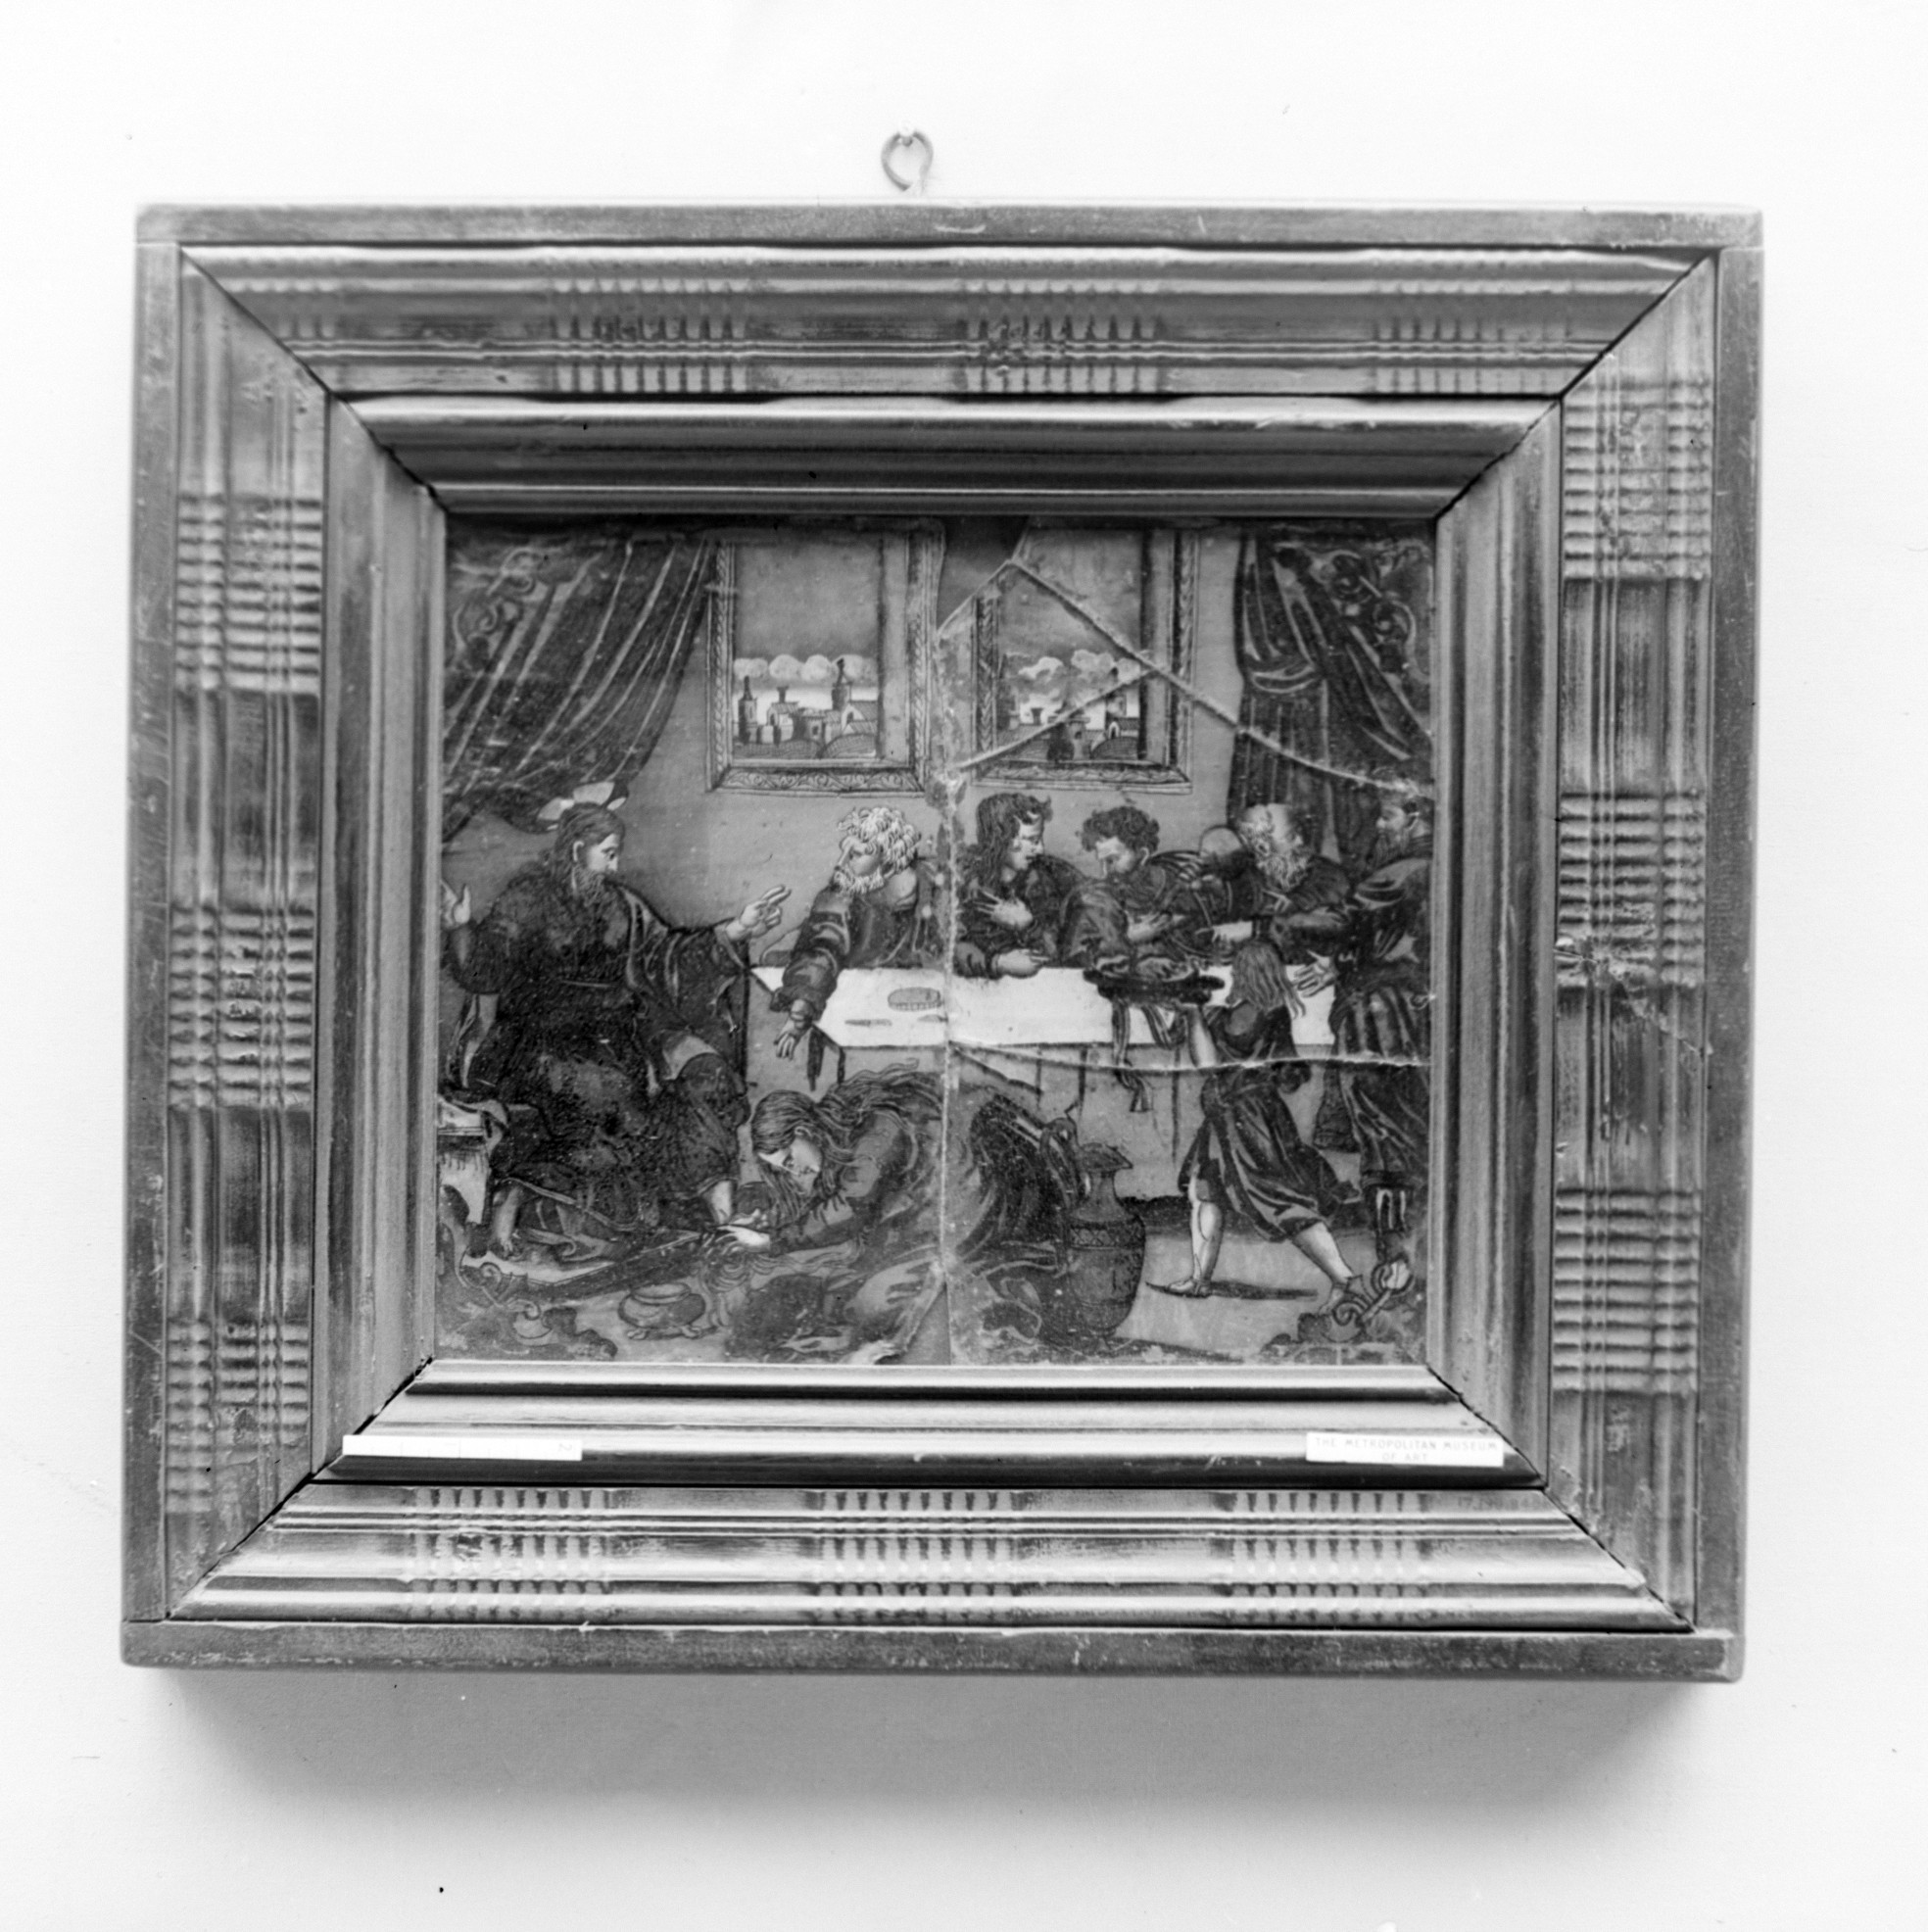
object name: panel or plaque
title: Mary Magdalen bathing the feet of Christ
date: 1501-1600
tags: apostles,christ,mary magdalene